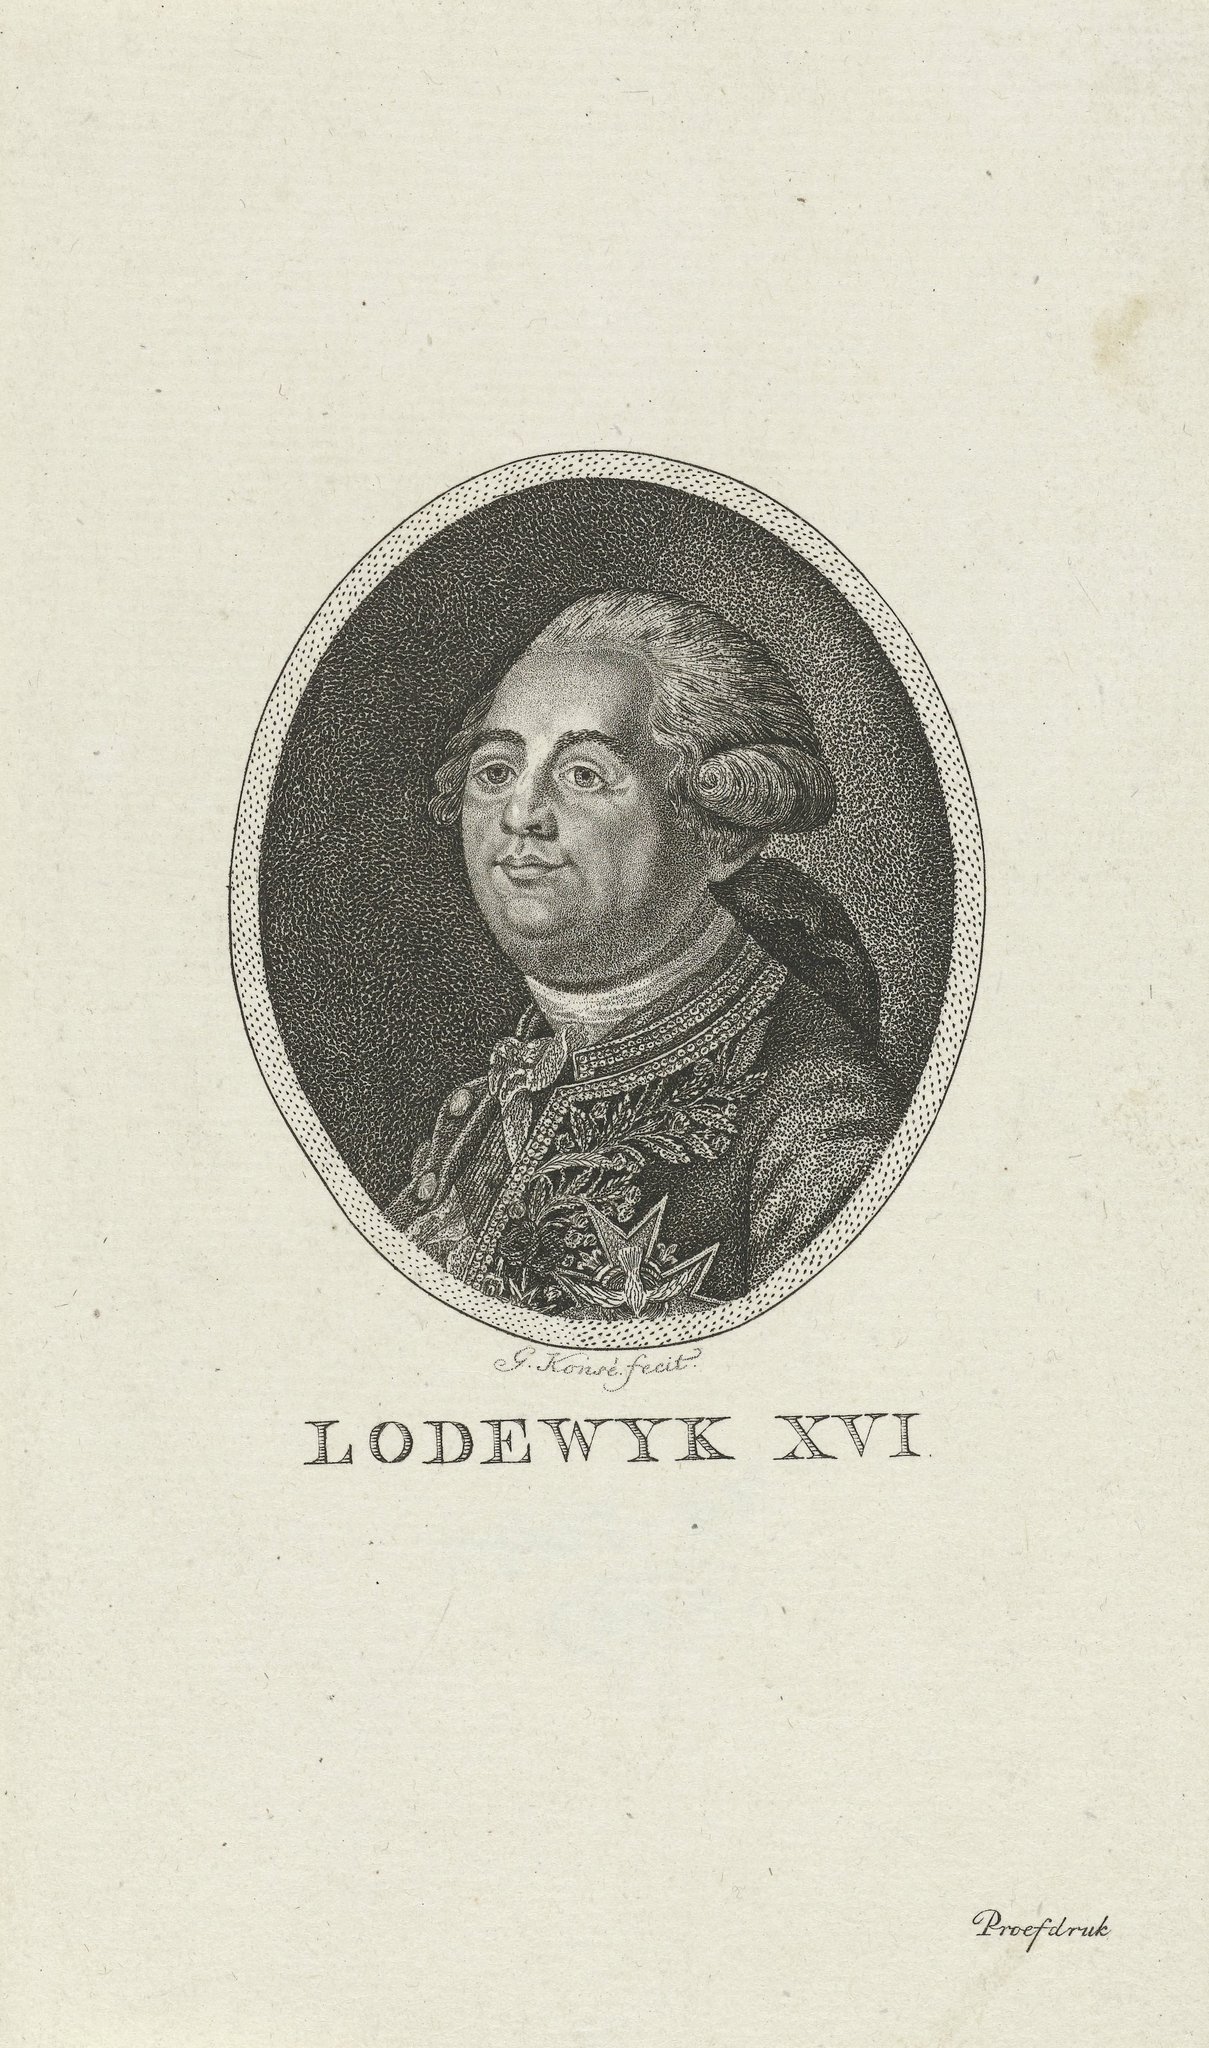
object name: print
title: Portret van Lodewijk XVI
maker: gerrit konsé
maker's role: print maker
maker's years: 1751-1826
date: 1792-1808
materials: paper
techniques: engraving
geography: amsterdam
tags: paris, lodewijk xvi (koning van frankrijk)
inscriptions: collector's mark: Lugt 2228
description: Portret van Lodewijk XVI, koning van Frankrijk (1754-93). Buste naar links in een ovale omlijsting.